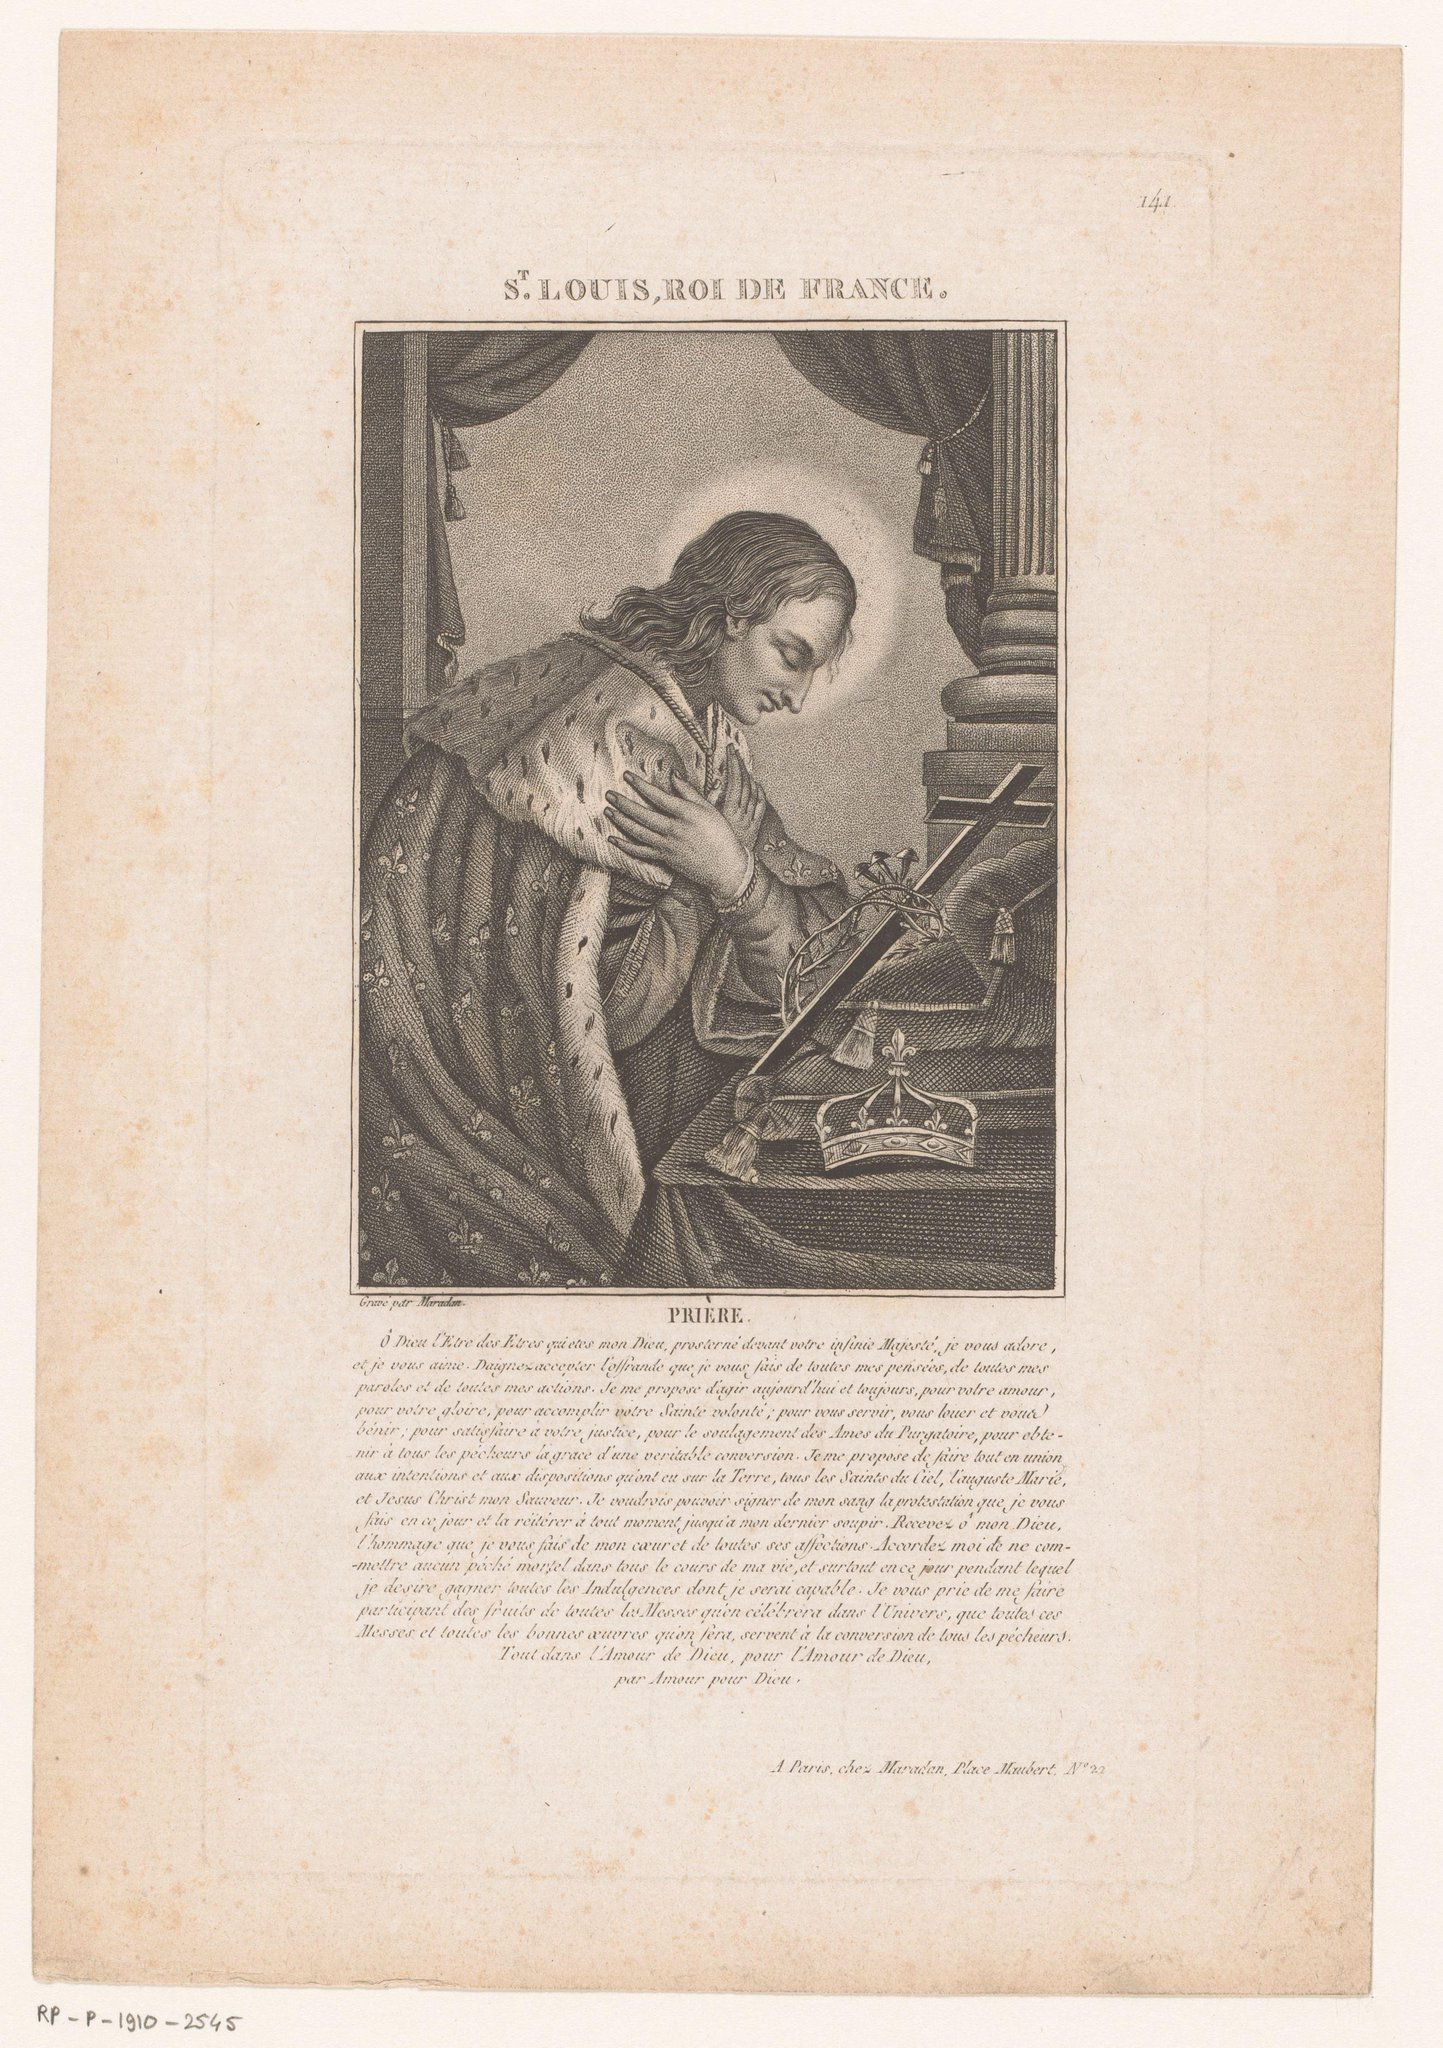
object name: print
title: St. Louis, roi de France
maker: françois maradan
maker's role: print maker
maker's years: 1766-1816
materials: paper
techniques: engraving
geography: paris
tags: historical persons, king, one person praying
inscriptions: collector's mark: Lugt 2228